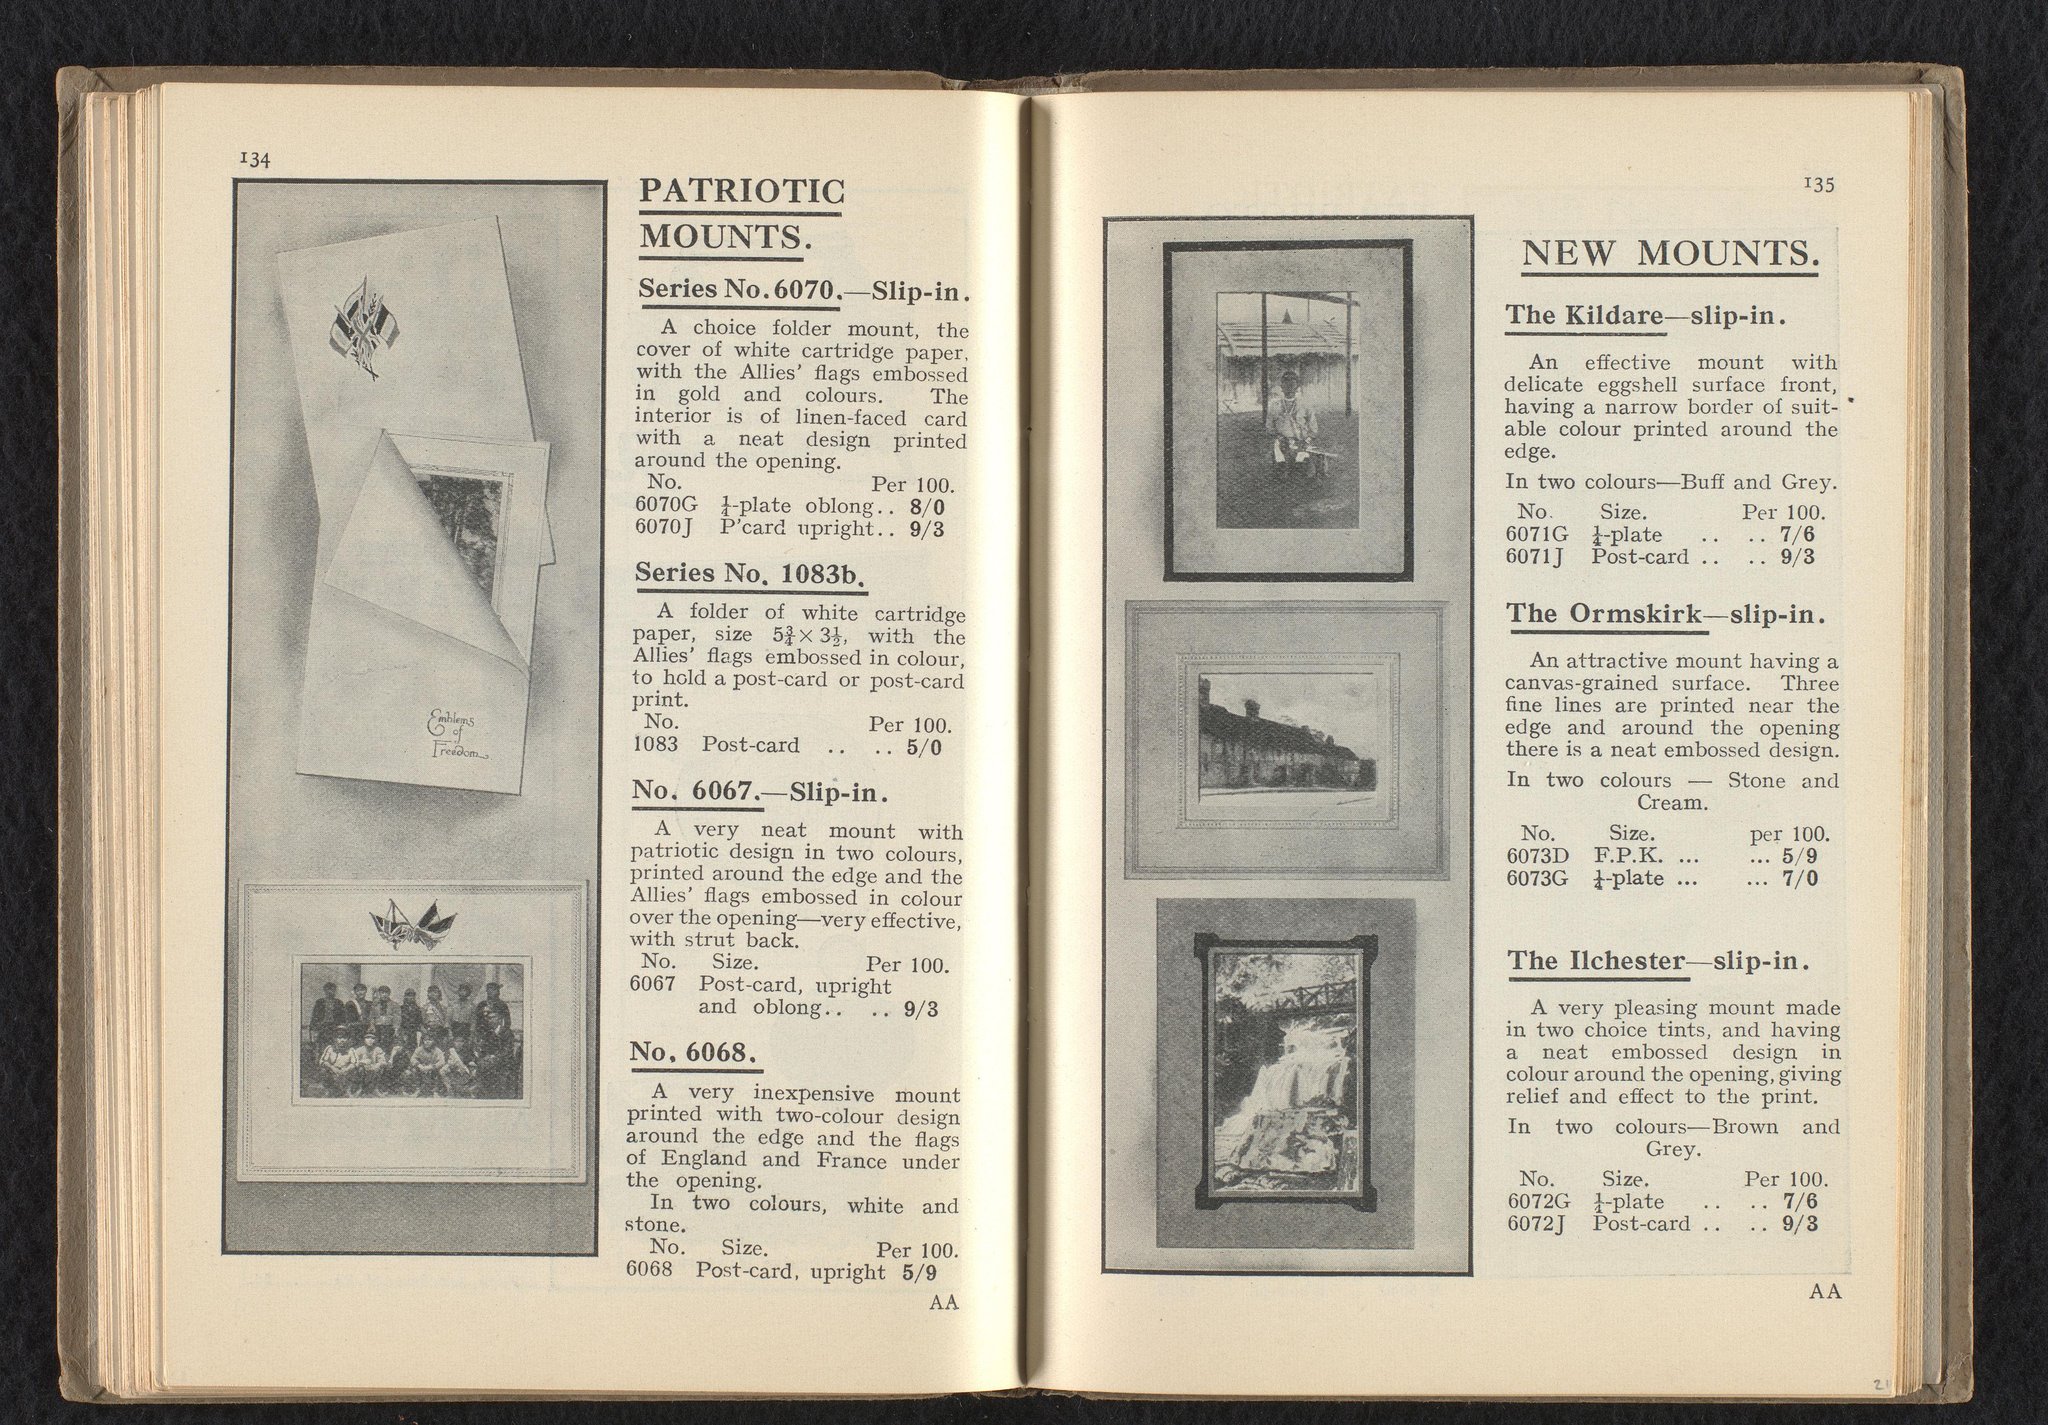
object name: page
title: Patriotic Mounts Series No. 6070, No. 6067 & No. 6068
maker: Anonymous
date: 1907-1912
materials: paper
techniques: letterpress printing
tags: photograph, 'passe-partout'